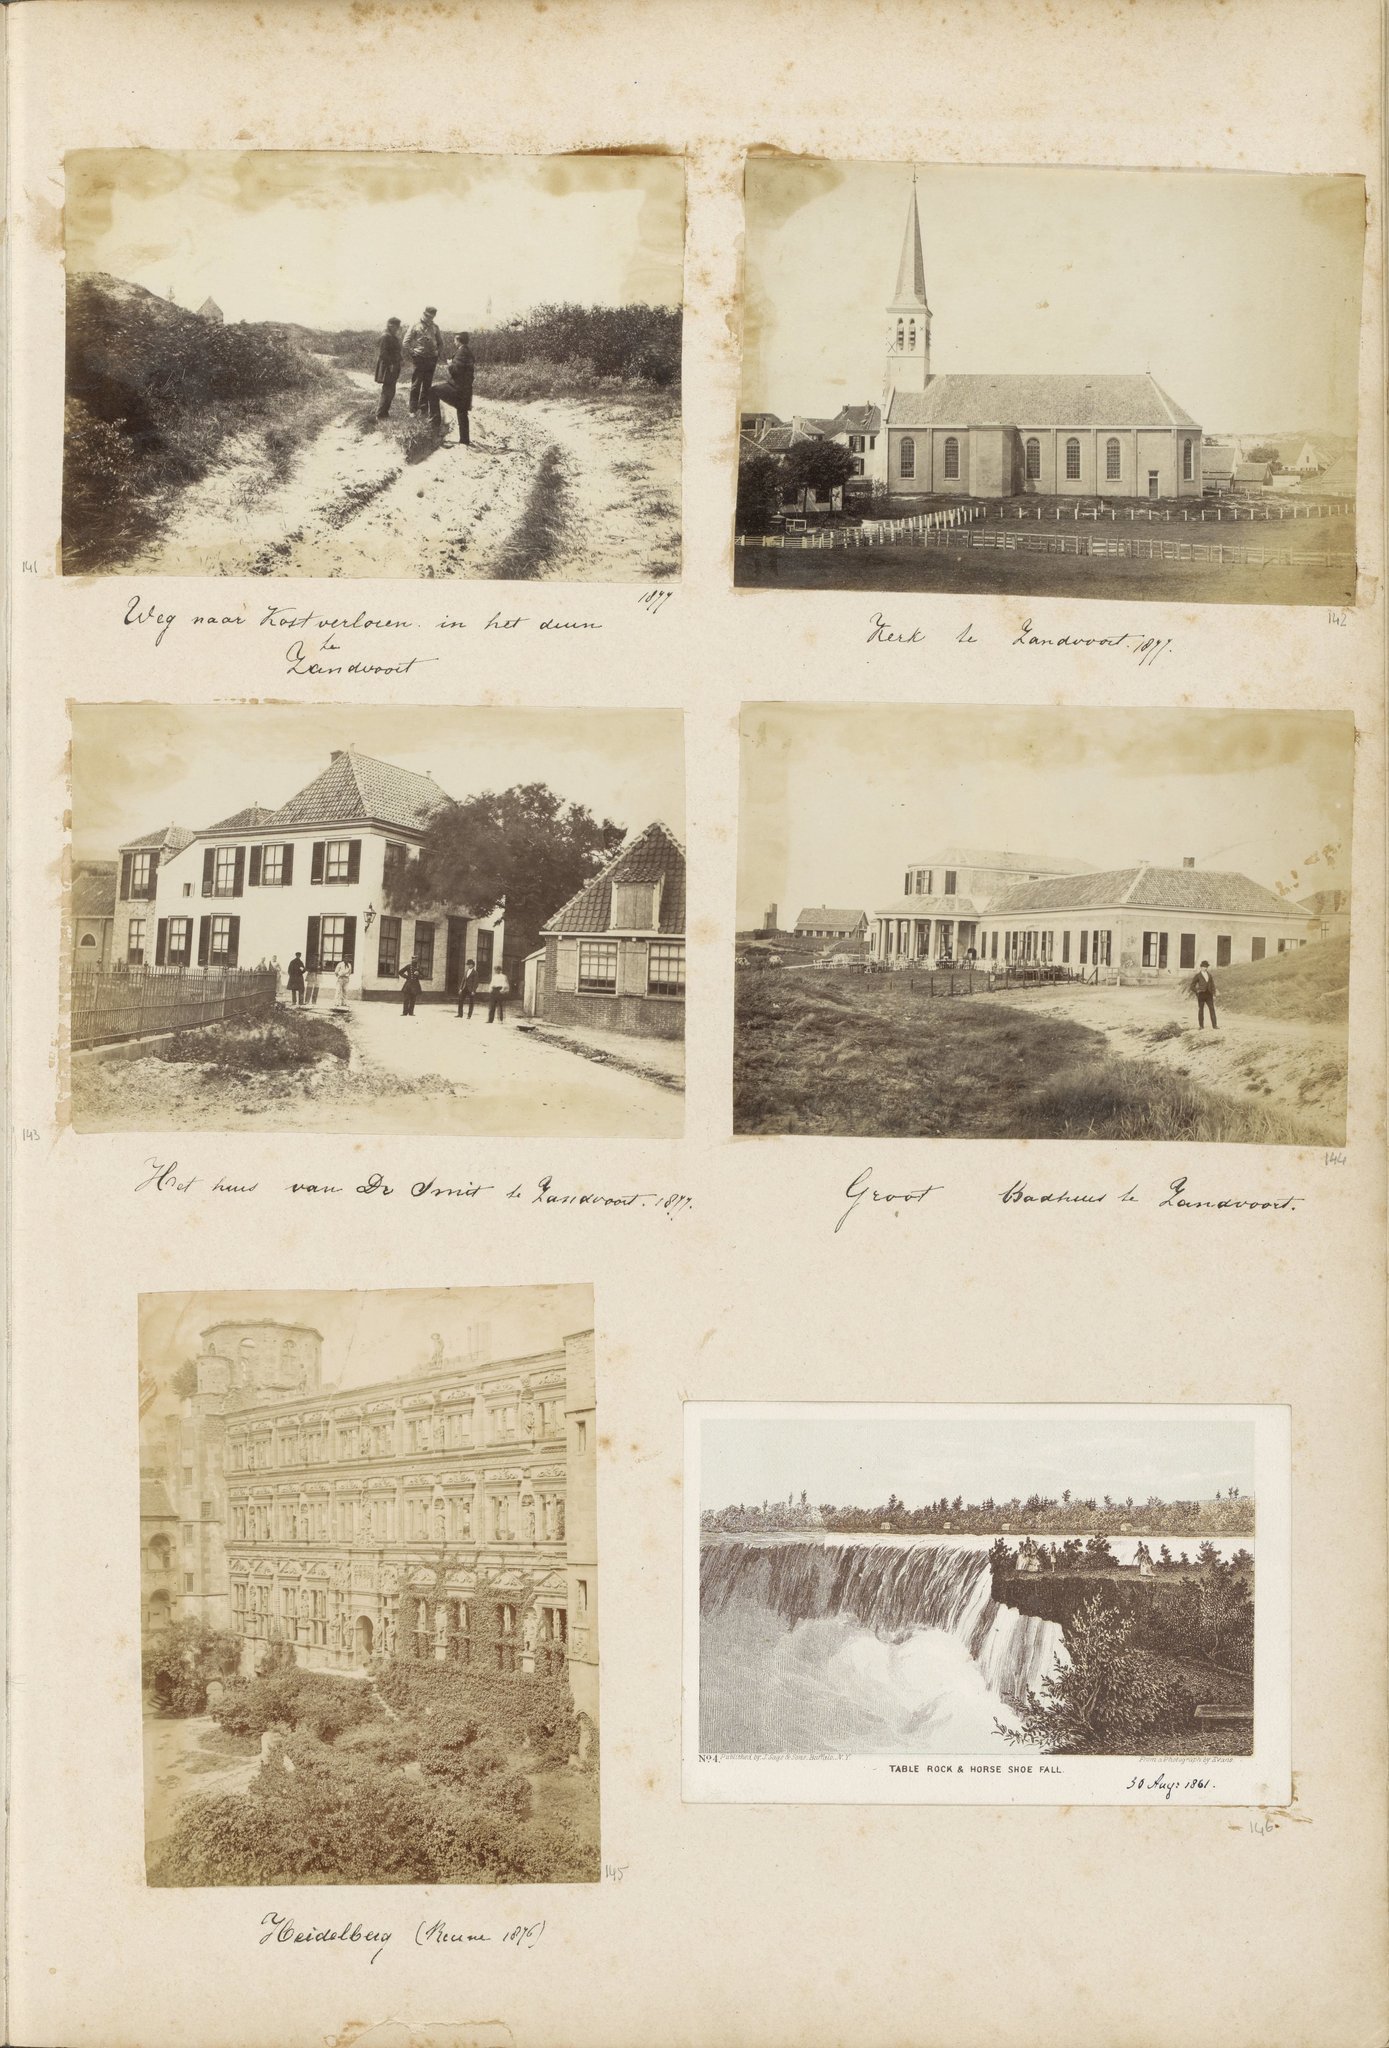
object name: print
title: Gezicht op Table Rock en de Horseshoe Falls (Niagarawatervallen)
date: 1861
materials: paper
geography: buffalo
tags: waterfall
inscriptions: number: ‘No. 4’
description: Onderdeel van Fotoalbum van Robert Daniel Crommelin (1841-1907).